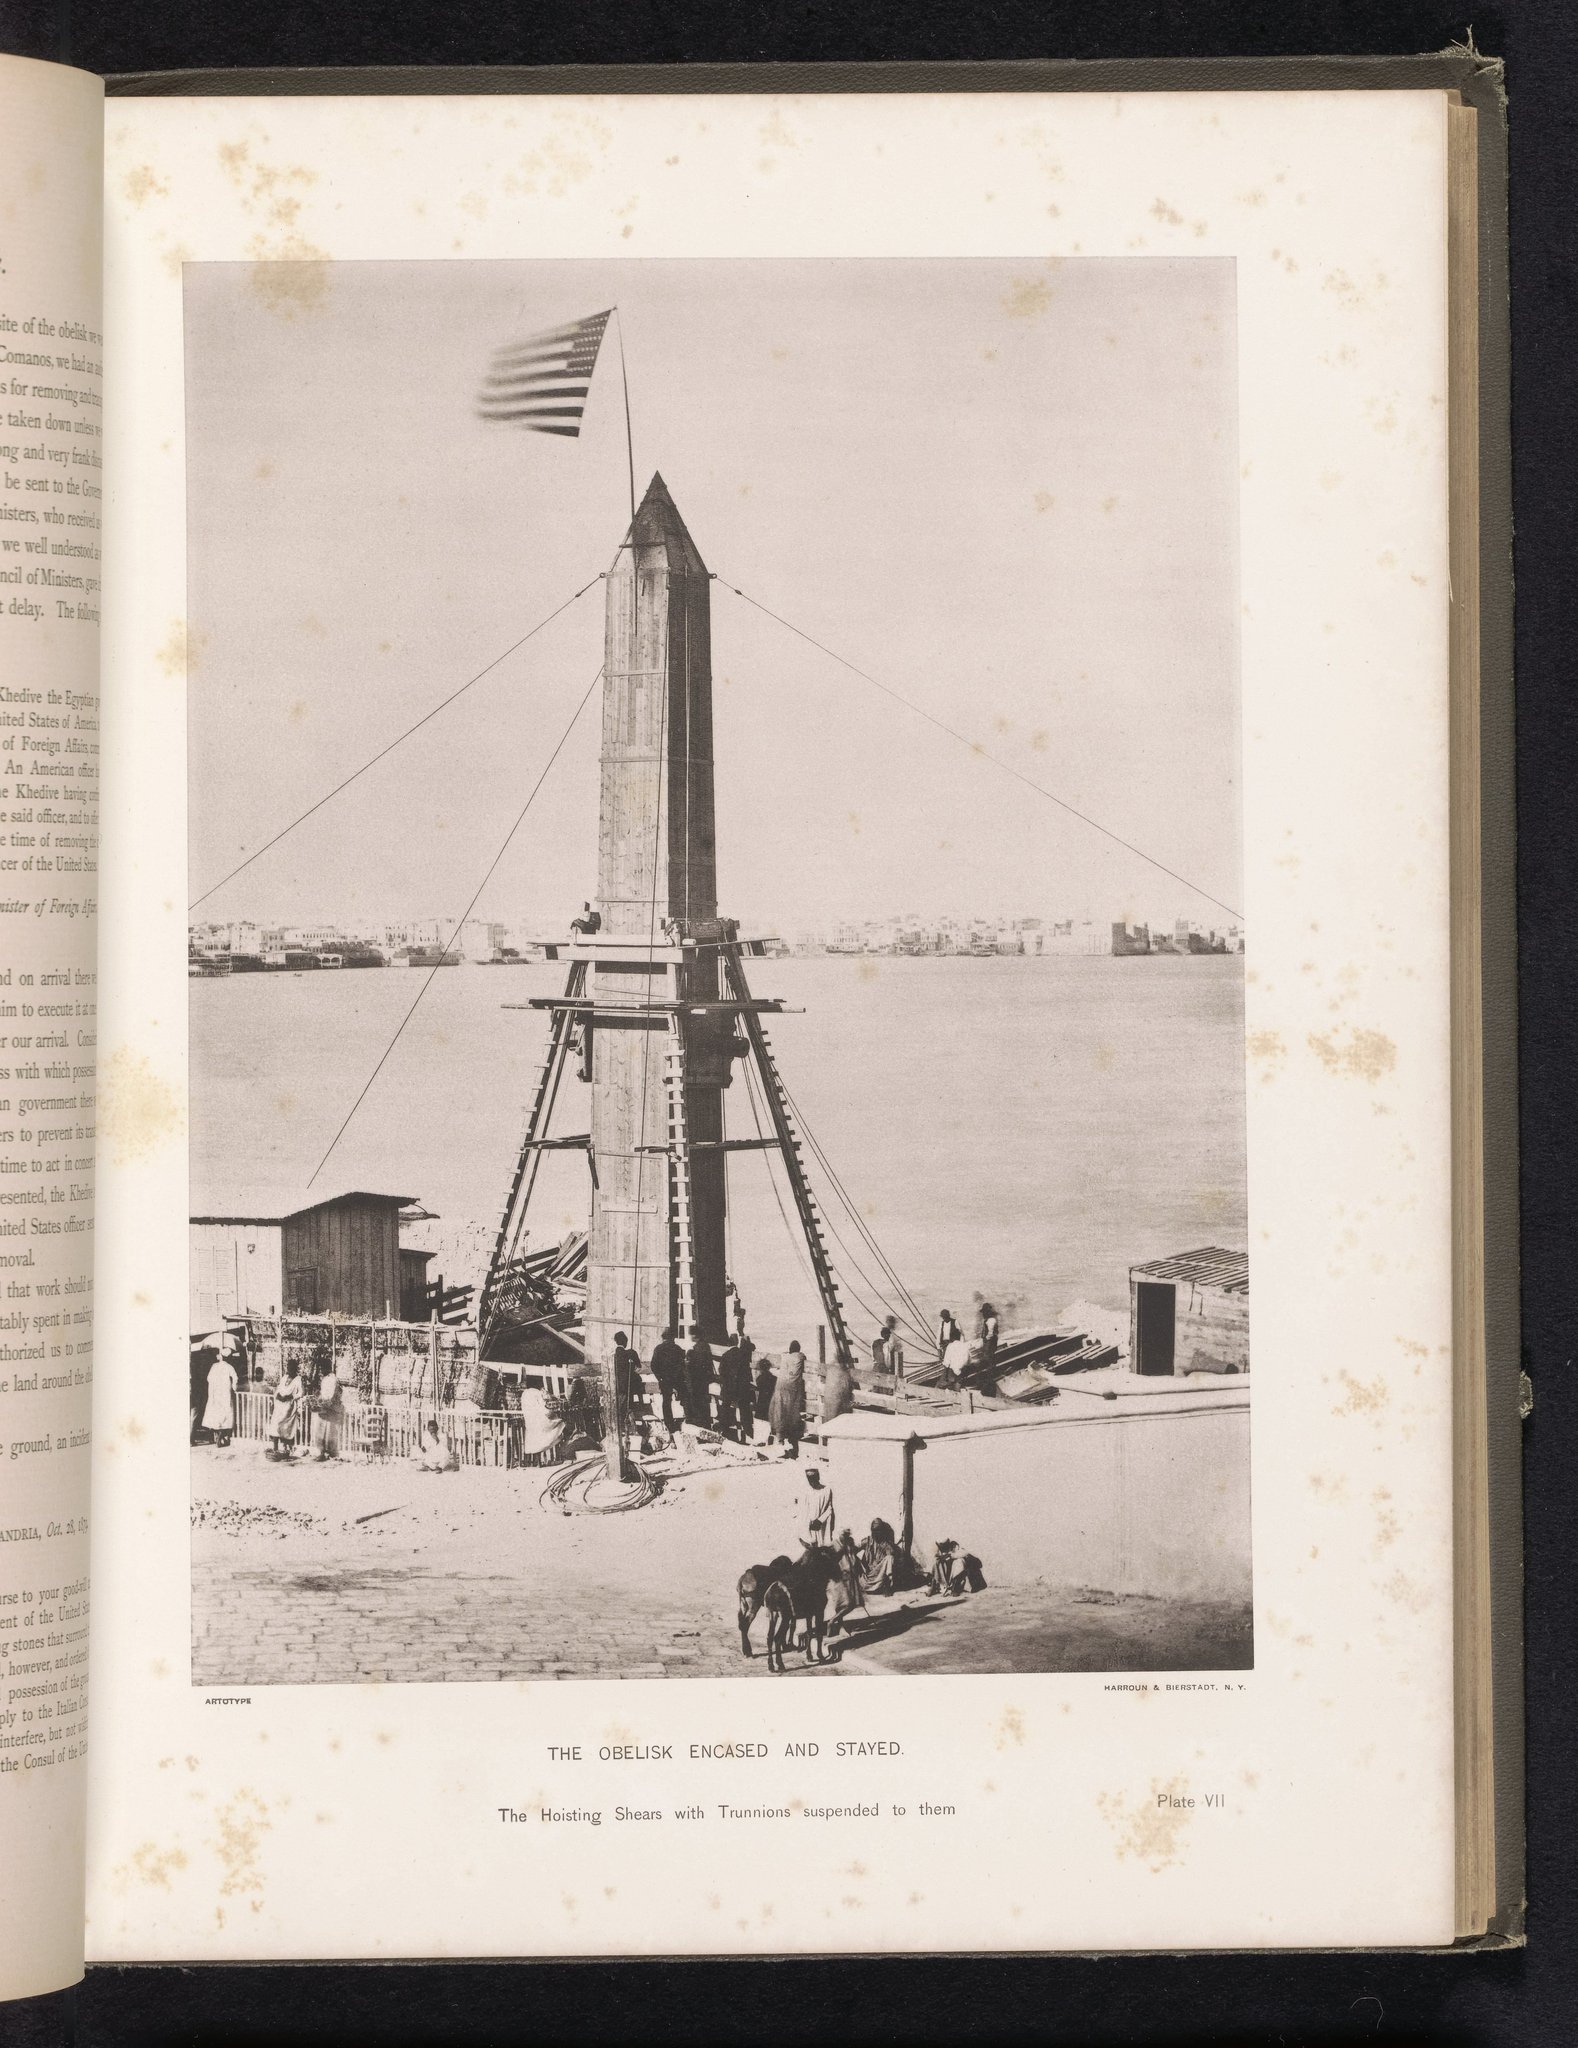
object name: photomechanical print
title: The obelisk encased and stayed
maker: Anonymous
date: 1879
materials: paper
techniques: photograph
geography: alexandria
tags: obelisk, needle, scaffold (~ building activities)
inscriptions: inscription: ‘The Hoisting Shears with Trunnions suspended to them’, number: ‘Plate VII’